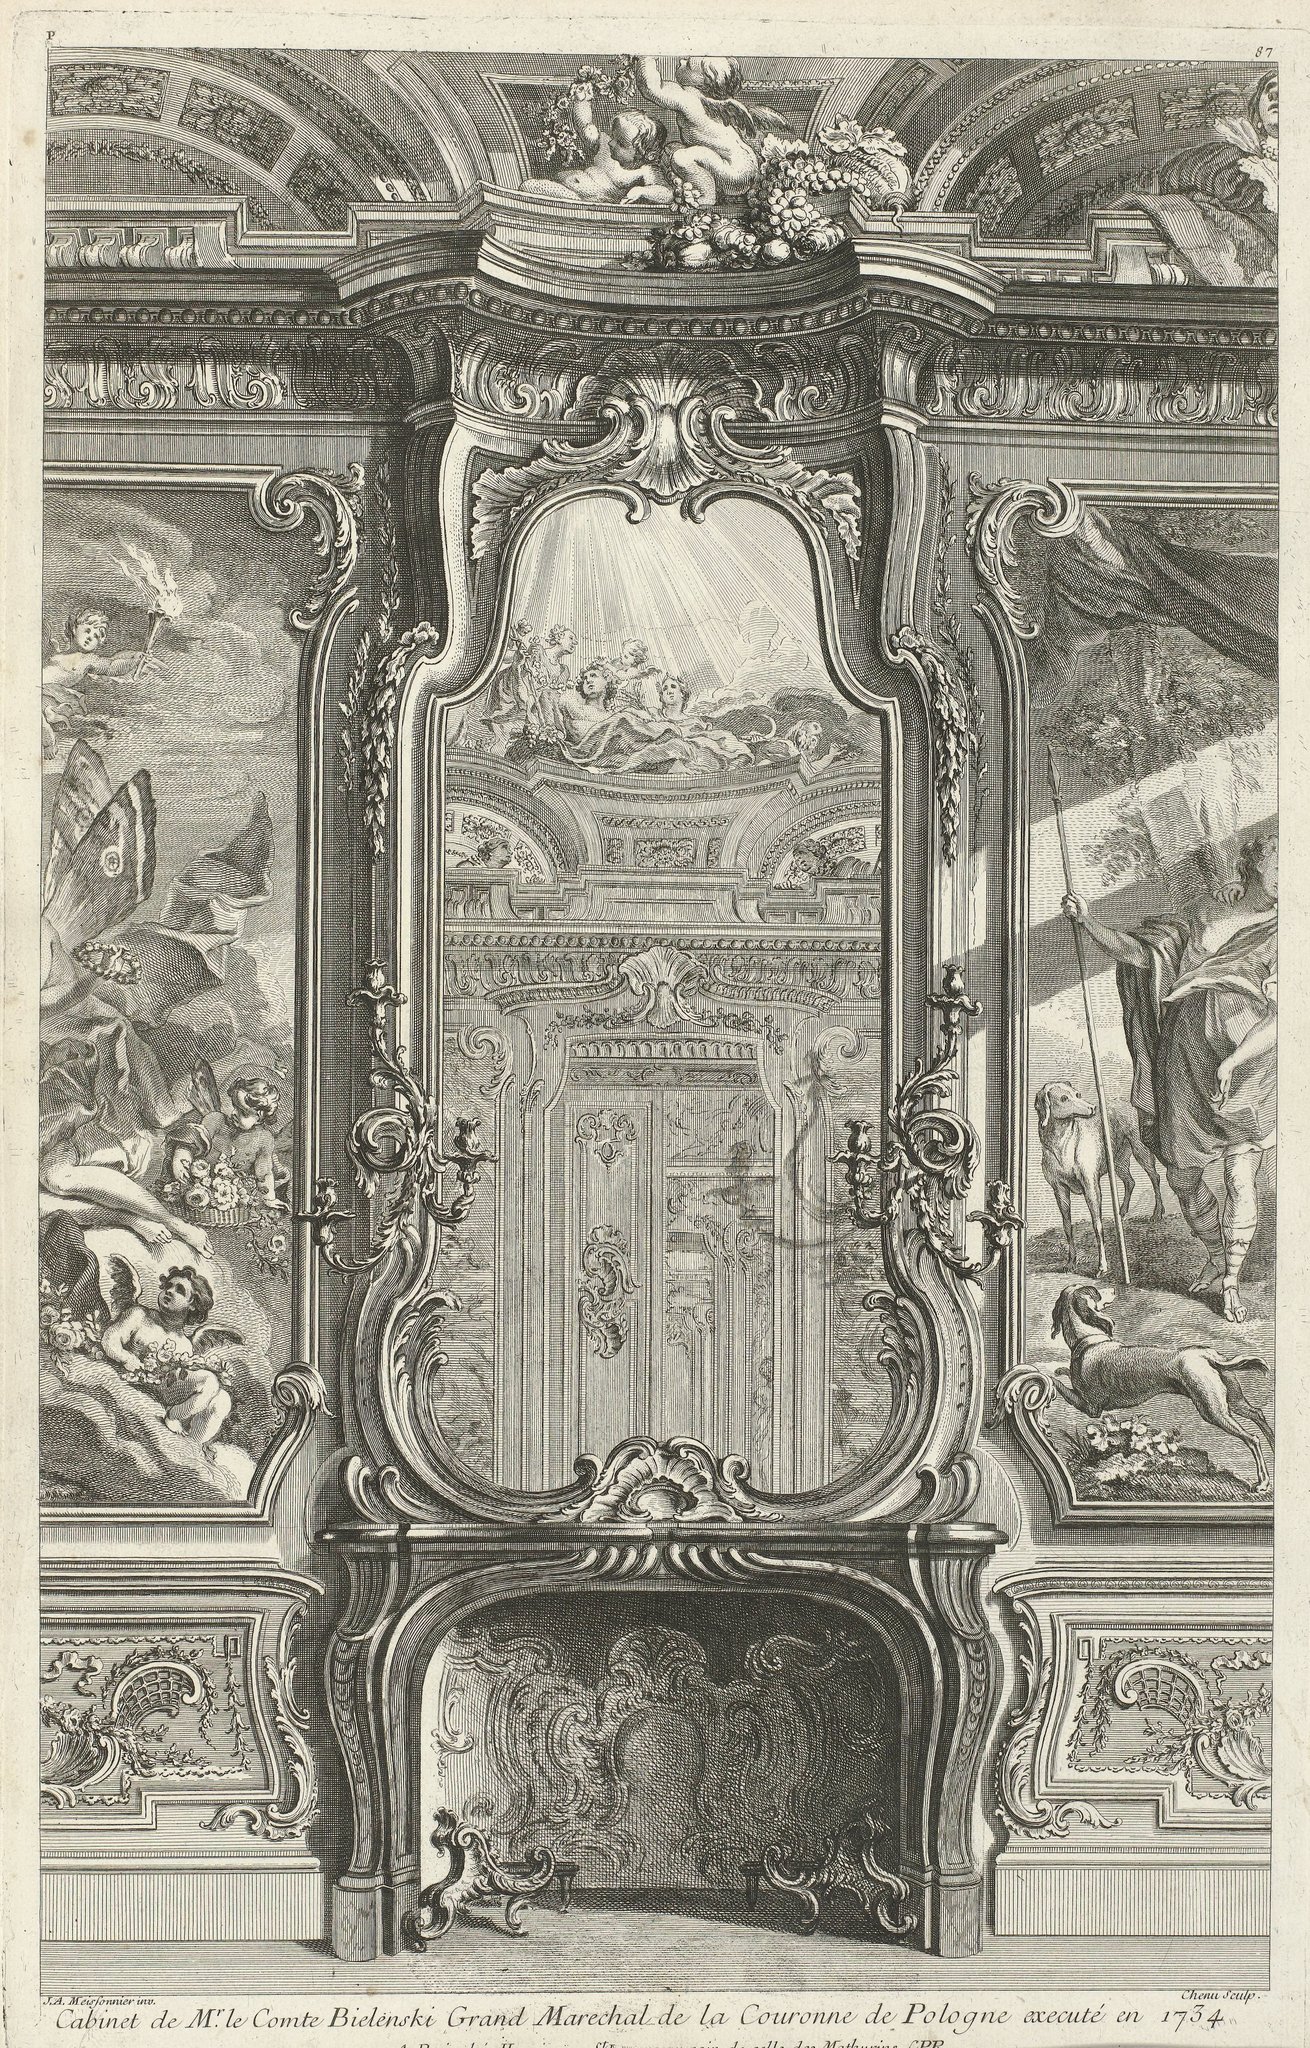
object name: album leaf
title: Oeuvre de Juste Aurele Meissonnier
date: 1738-1749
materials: paper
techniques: etching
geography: paris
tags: art collection, art gallery, decorations (interior of the house)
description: Deze prent maakt deel uit van een album.